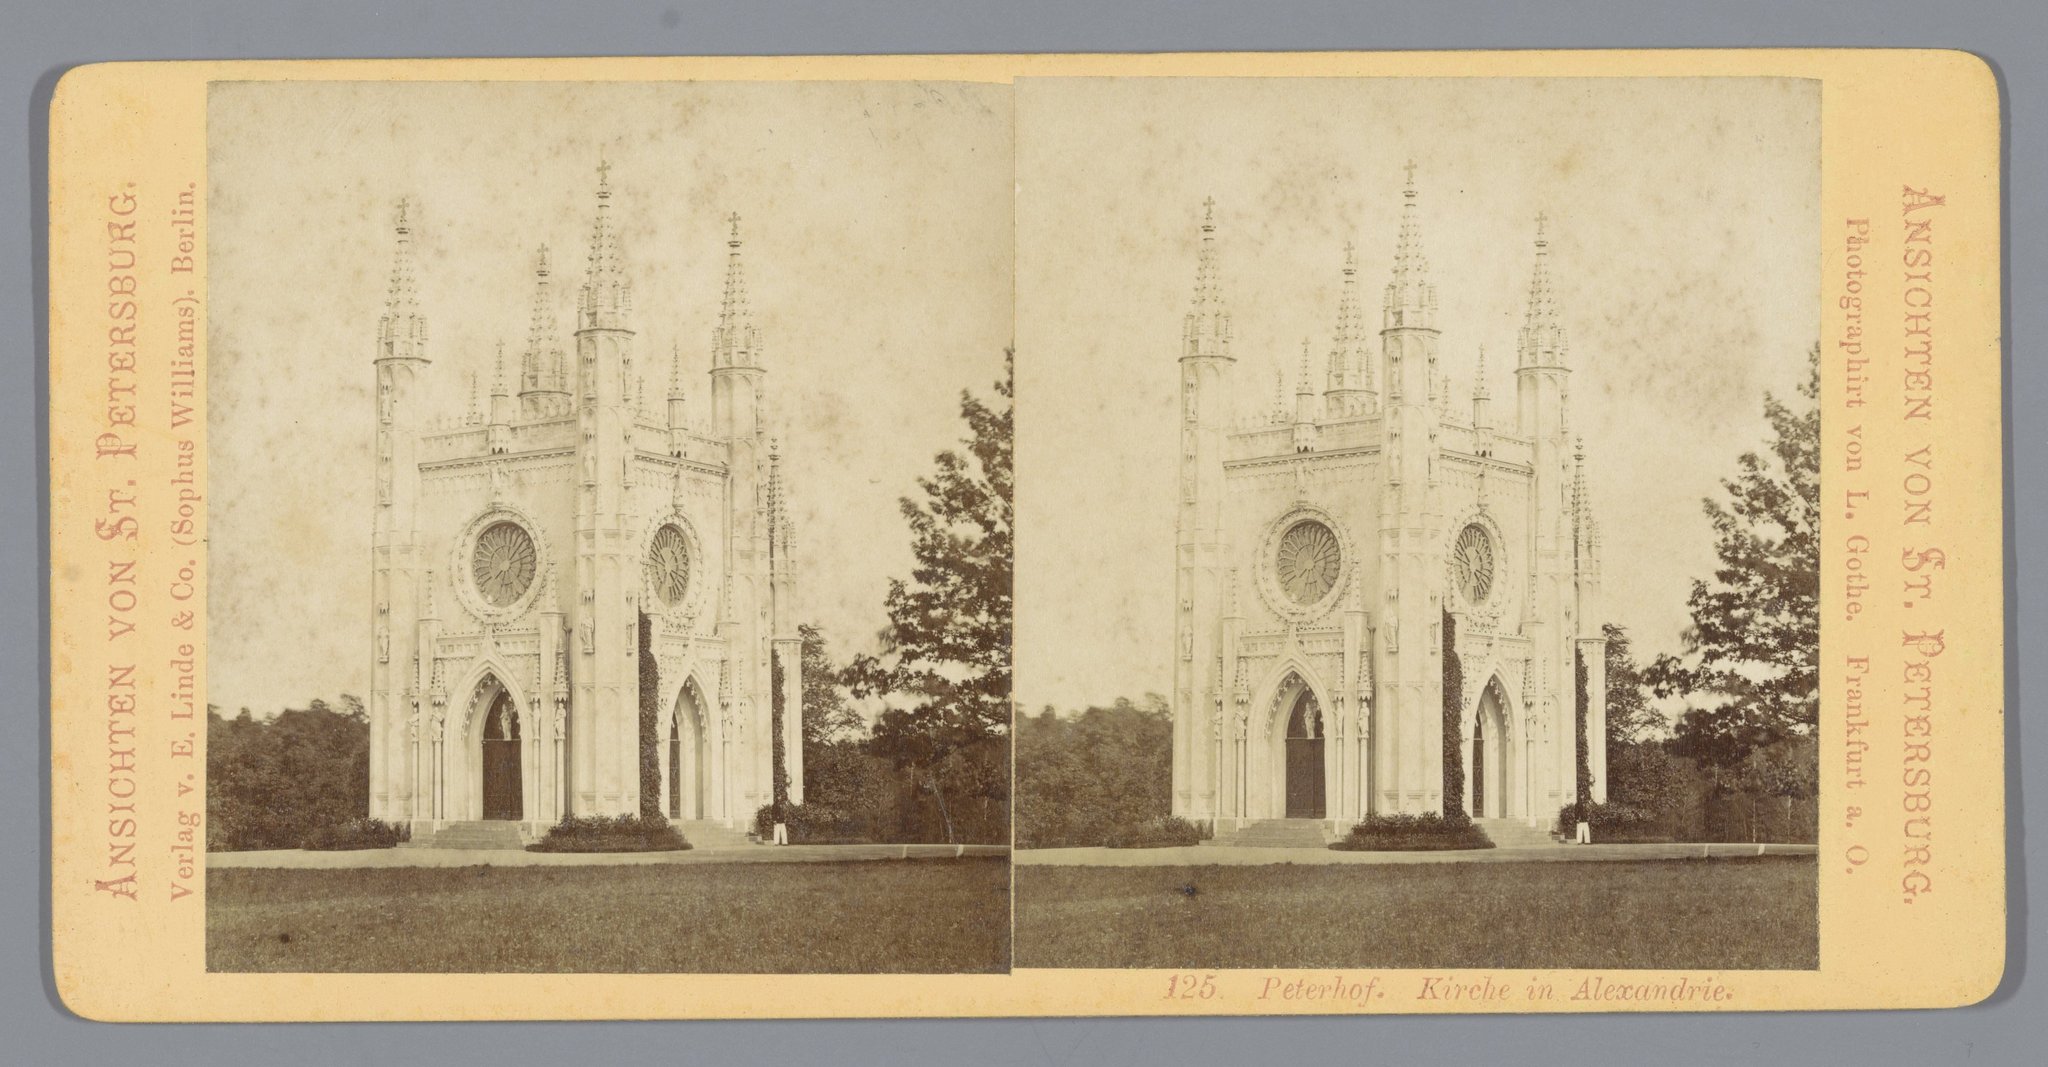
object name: stereograph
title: Peterhof. Kirche in Alexandrie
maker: louis gothe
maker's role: fotograaf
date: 1850-1880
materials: cardboard, photographic support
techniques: albumen print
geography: berlin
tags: church (exterior) - qq - small church, chapel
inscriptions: inscription: ‘Ansichten von St. Petersburg.’, number: ‘125.’